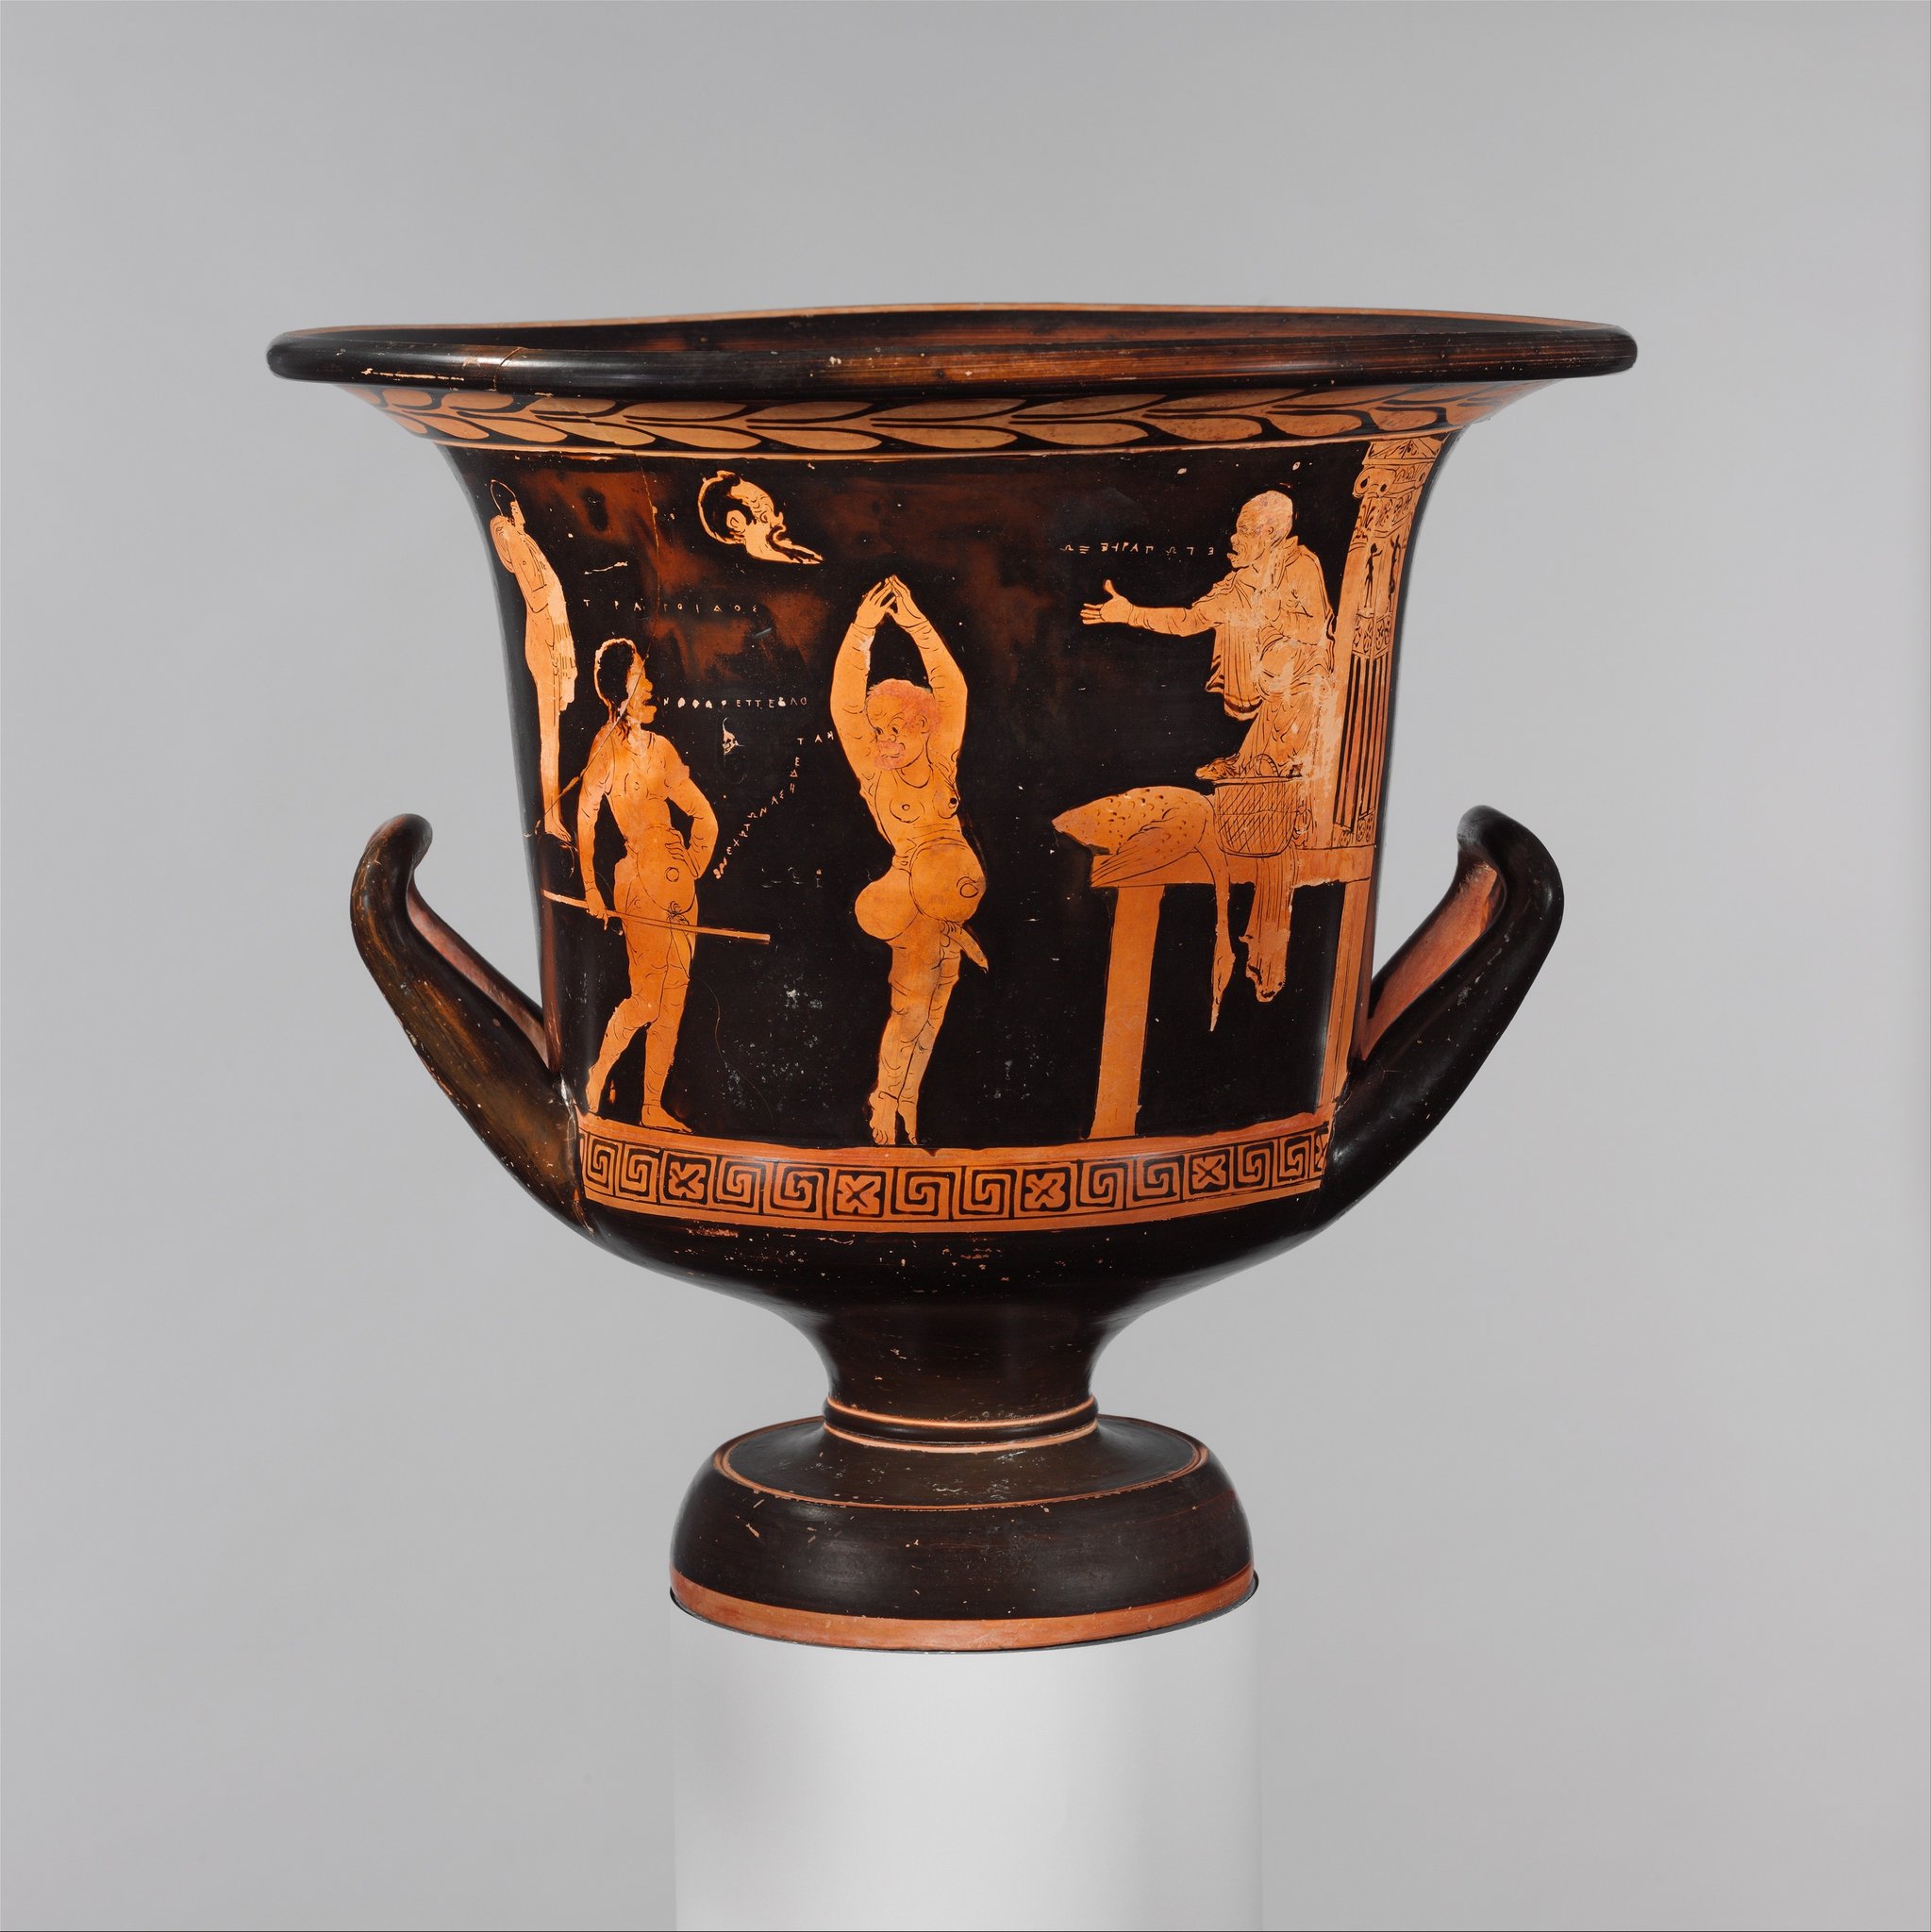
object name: calyx krater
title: Terracotta calyx-krater (mixing bowl)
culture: greek, south italian, lucanian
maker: dolon painter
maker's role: artist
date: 400-390 BCE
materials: terracotta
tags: geese,men,male nudes,actors